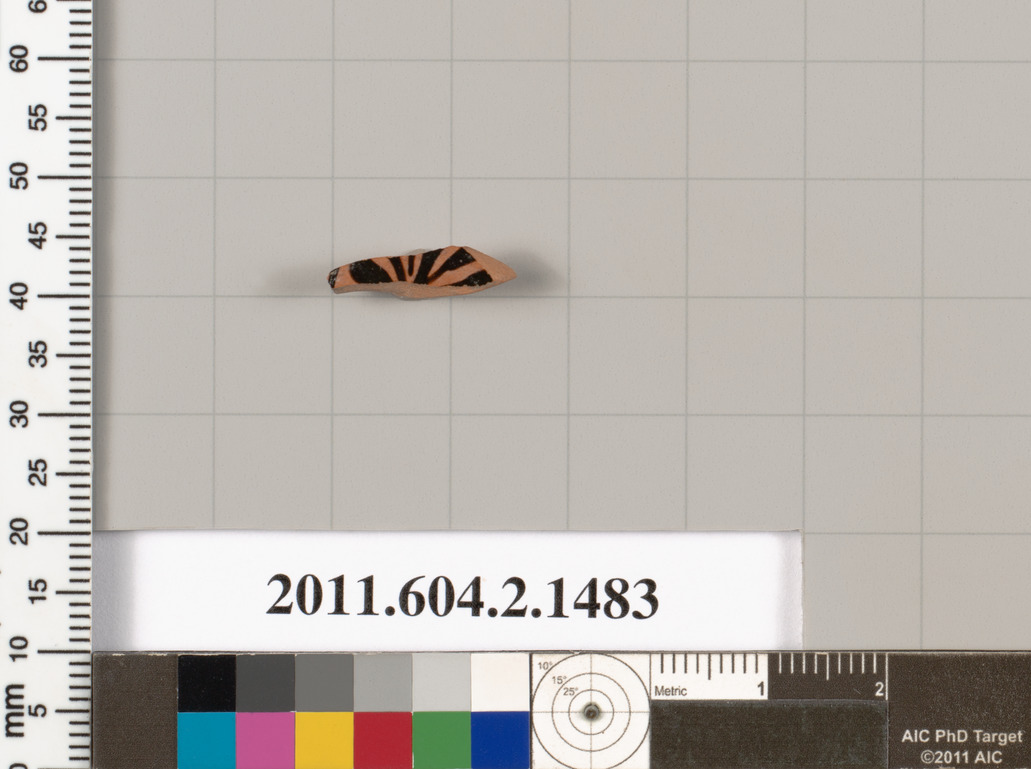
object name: skyphos fragment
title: Terracotta fragment of a skyphos (deep drinking cup)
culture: greek, attic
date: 534-468 BCE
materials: terracotta